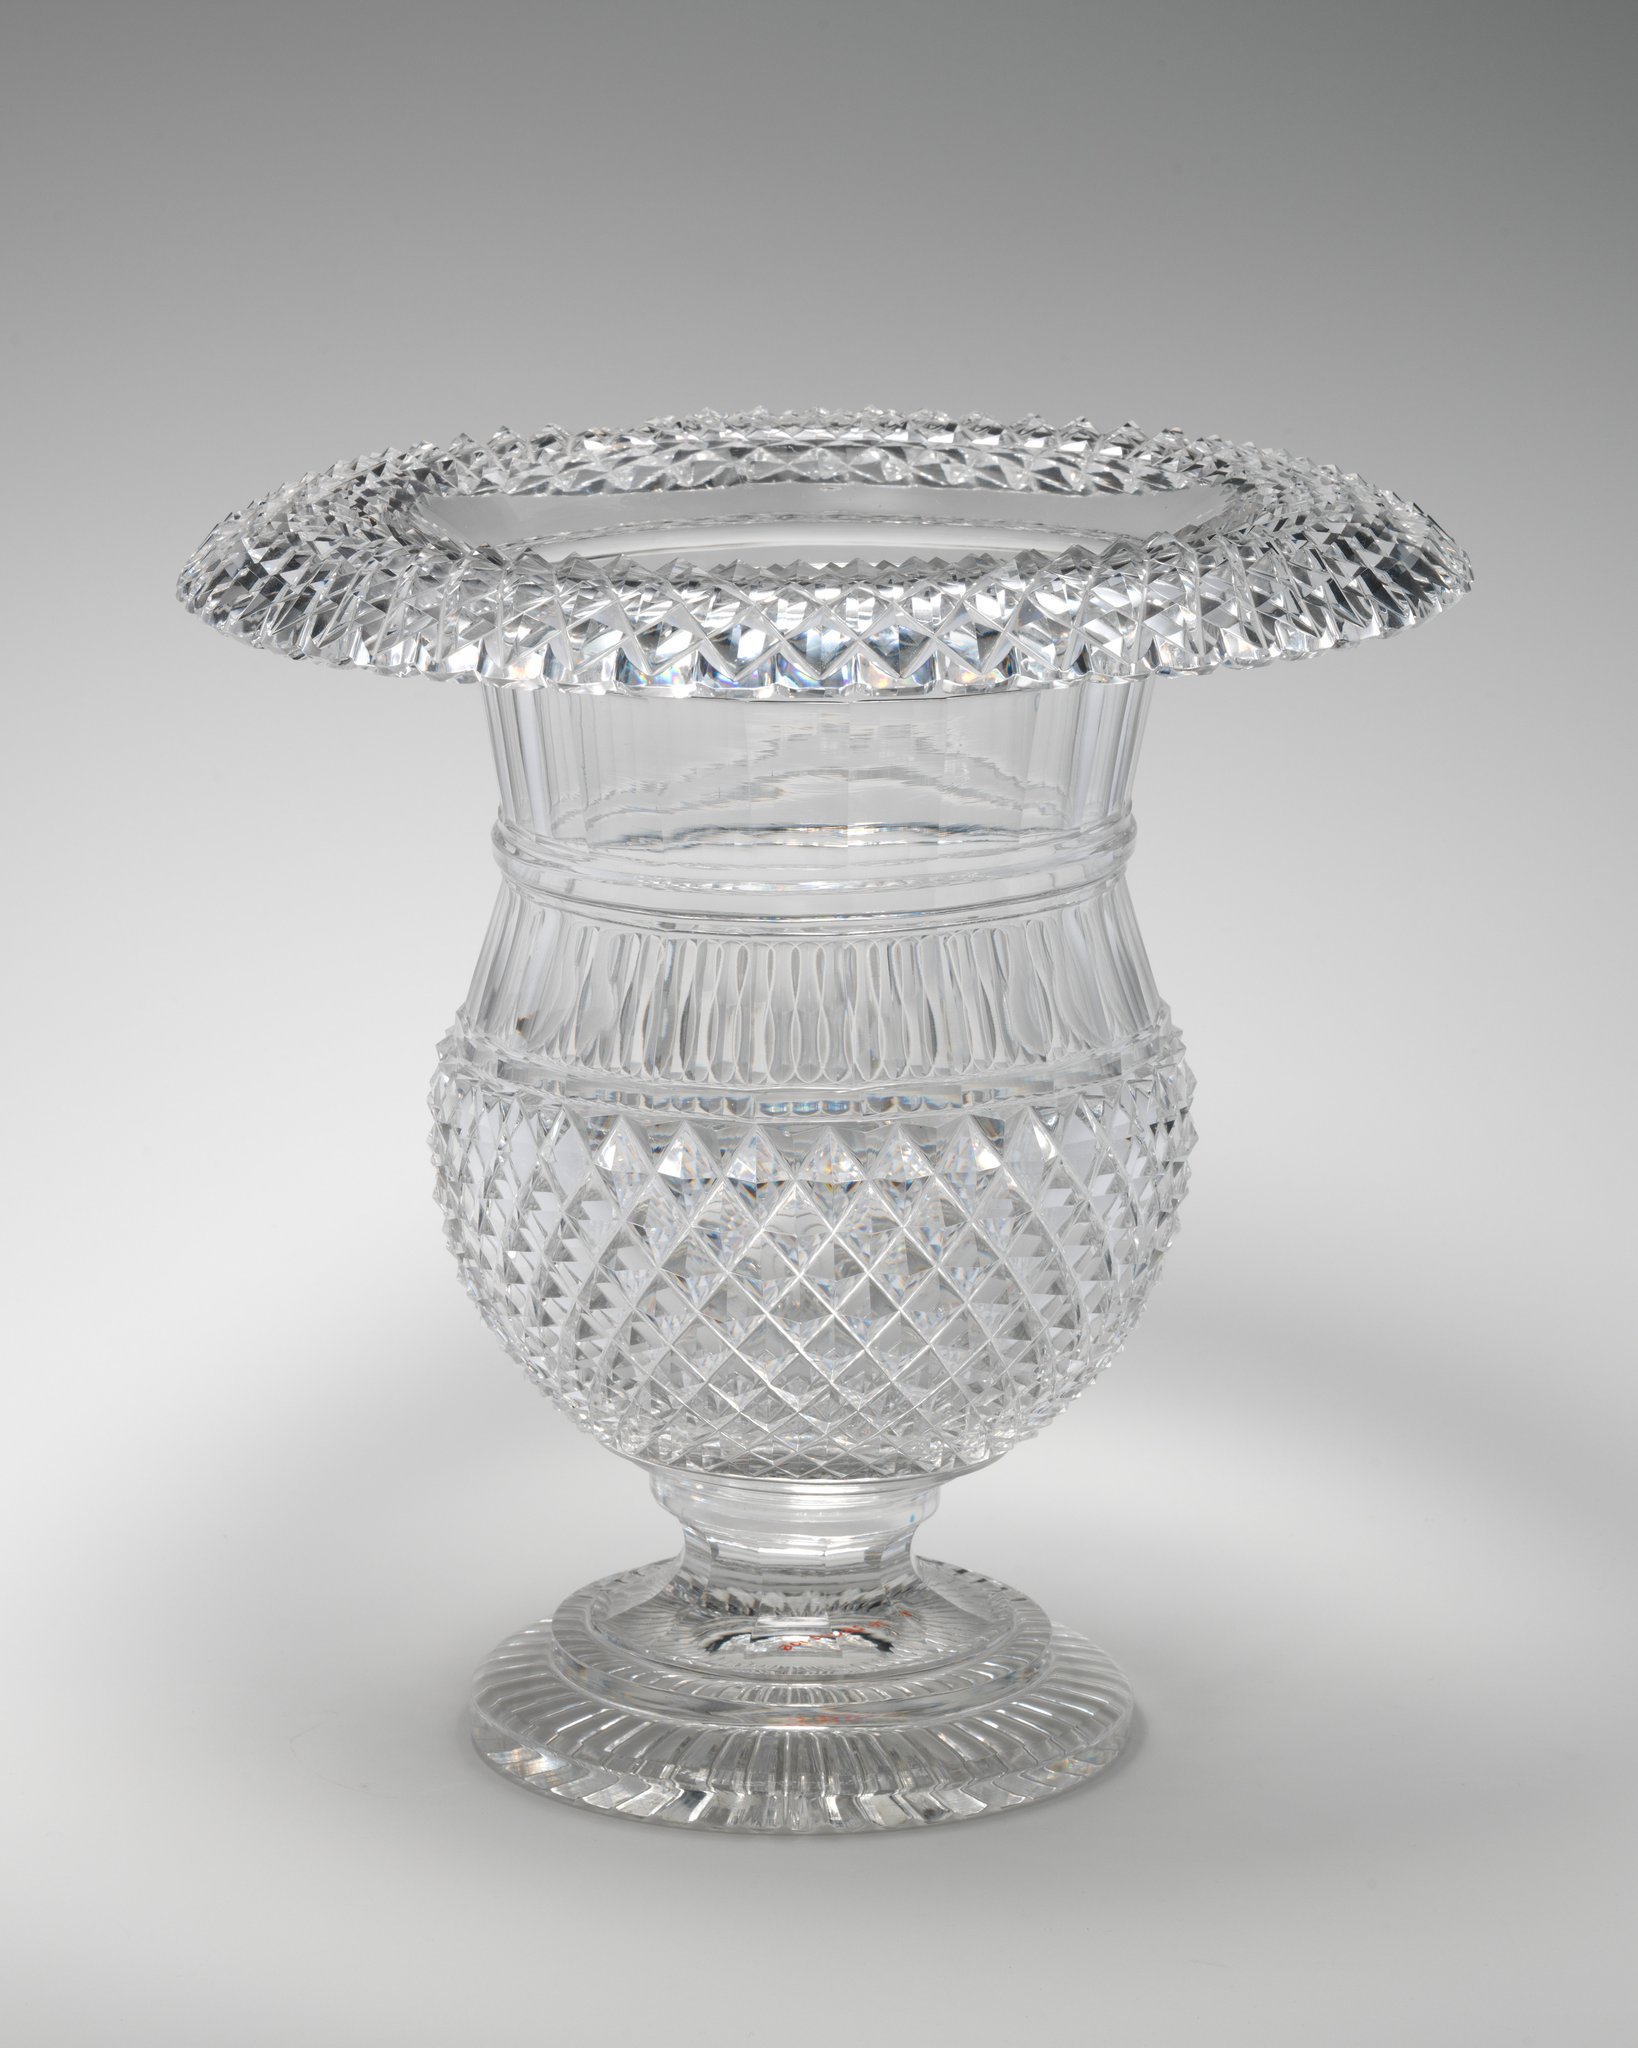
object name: vase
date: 1820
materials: glass